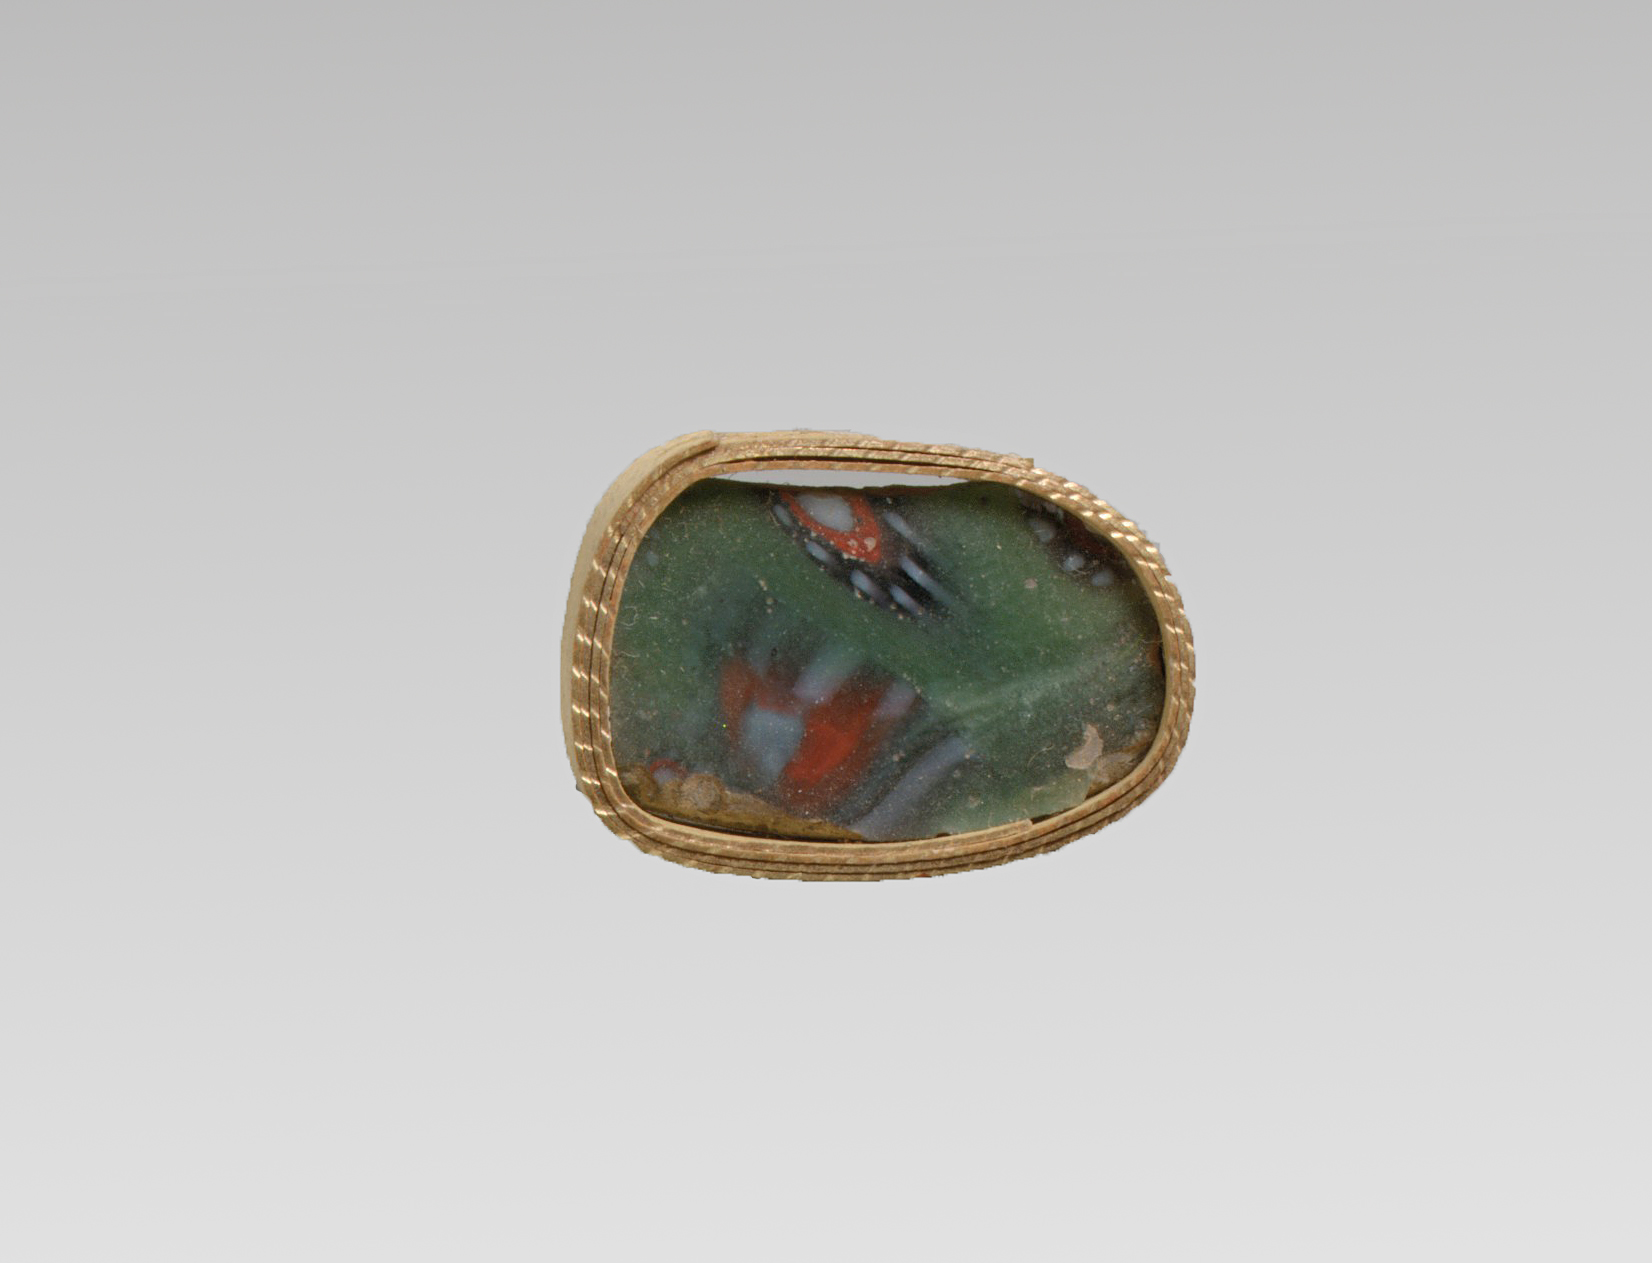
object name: fragment, mosaic base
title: Glass mosaic base fragment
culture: roman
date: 34 BCE-33 CE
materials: glass